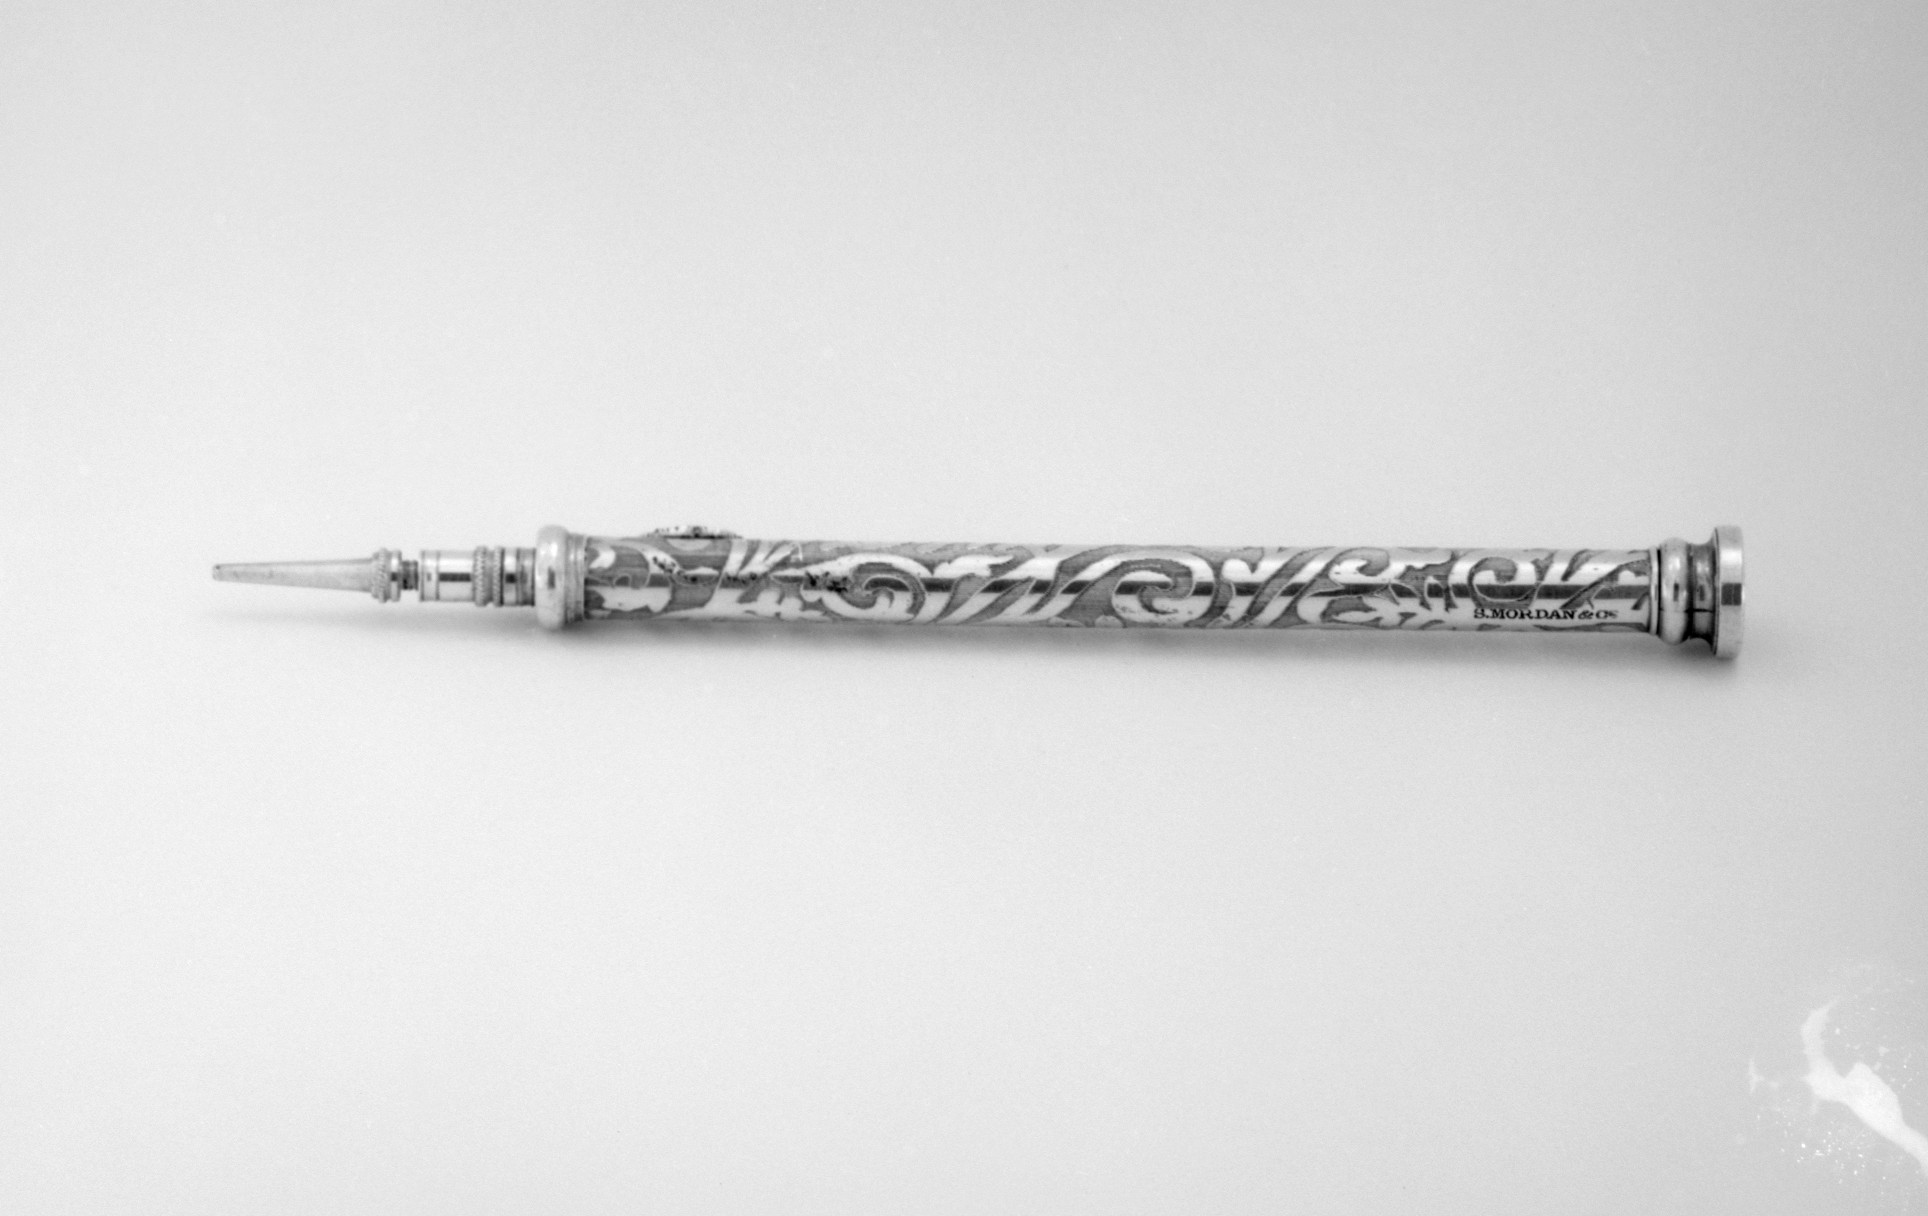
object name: pencil with eraser and lead holder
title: Pencil with eraser and lead holder (part of a set)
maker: s. mordan & co., england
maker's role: maker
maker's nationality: british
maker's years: 1823-1898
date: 1848-1849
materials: lead, silver